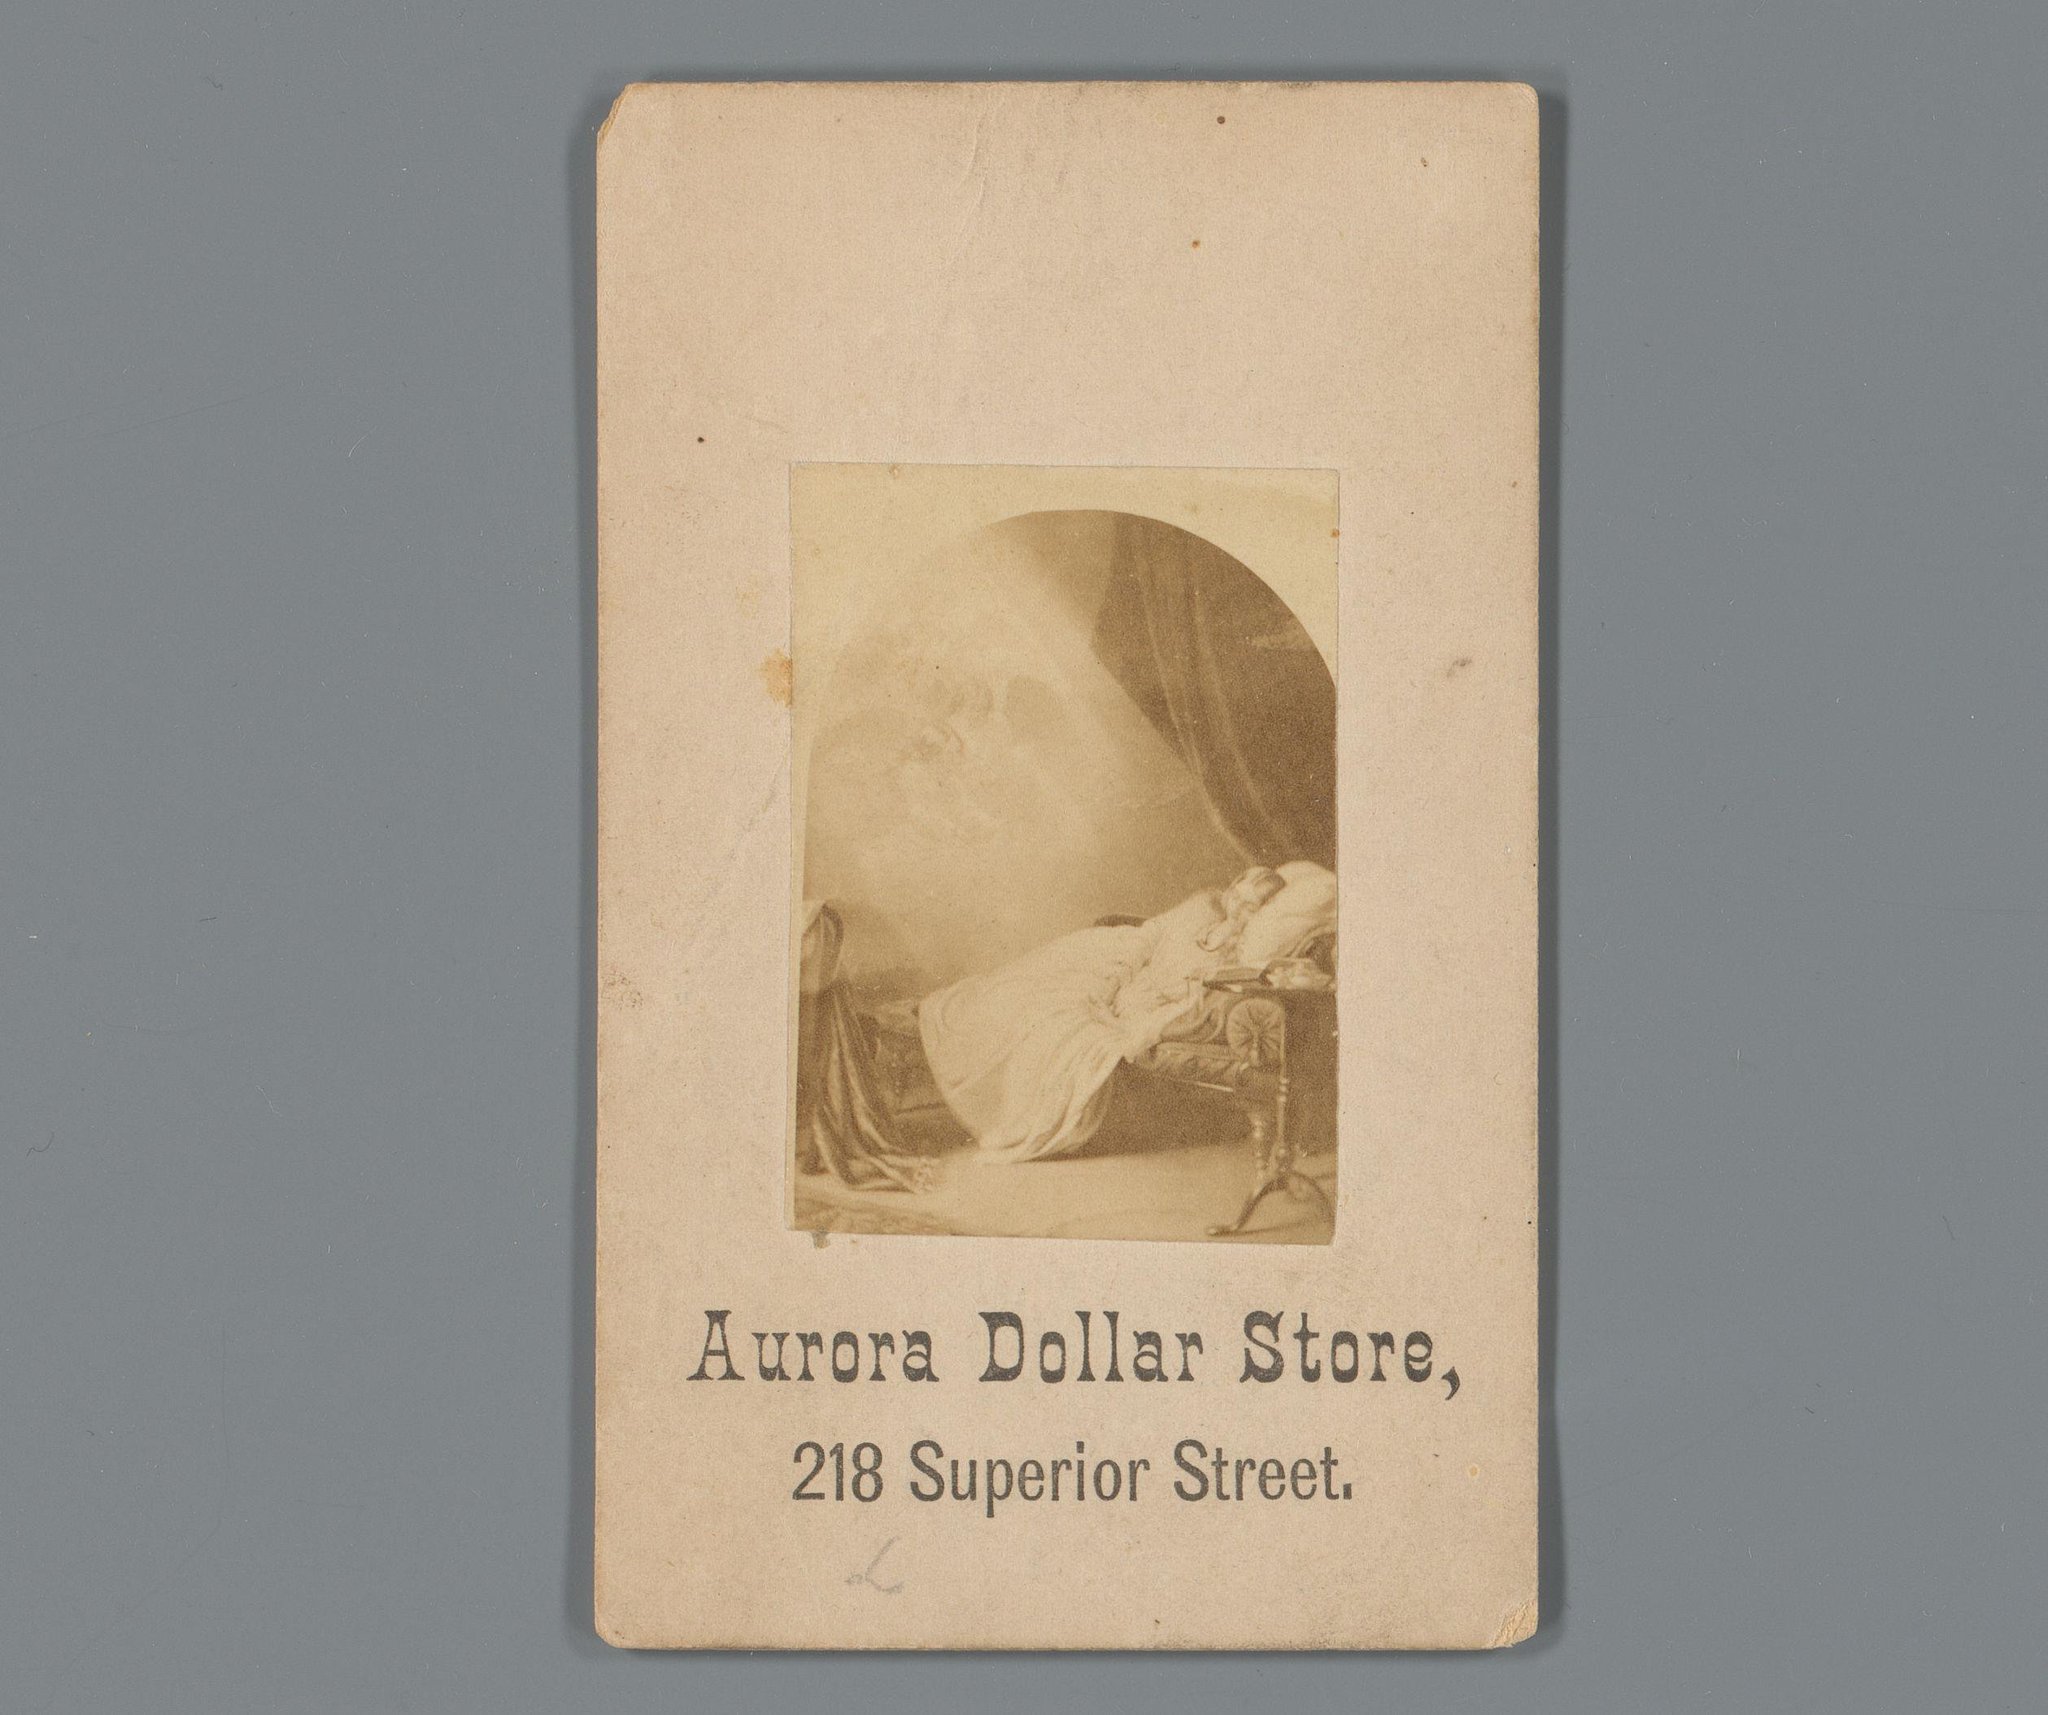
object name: carte de visite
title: Reclame voor Aurora Dollar Store met fotoreproductie van een schildering van een slapende vrouw, mogelijk Doornroosje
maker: Anonymous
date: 1850-1915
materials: cardboard, photographic support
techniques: albumen print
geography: united states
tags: dawn, advertising, sleeping in bed, sunbeams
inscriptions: inscription: ‘(...)’